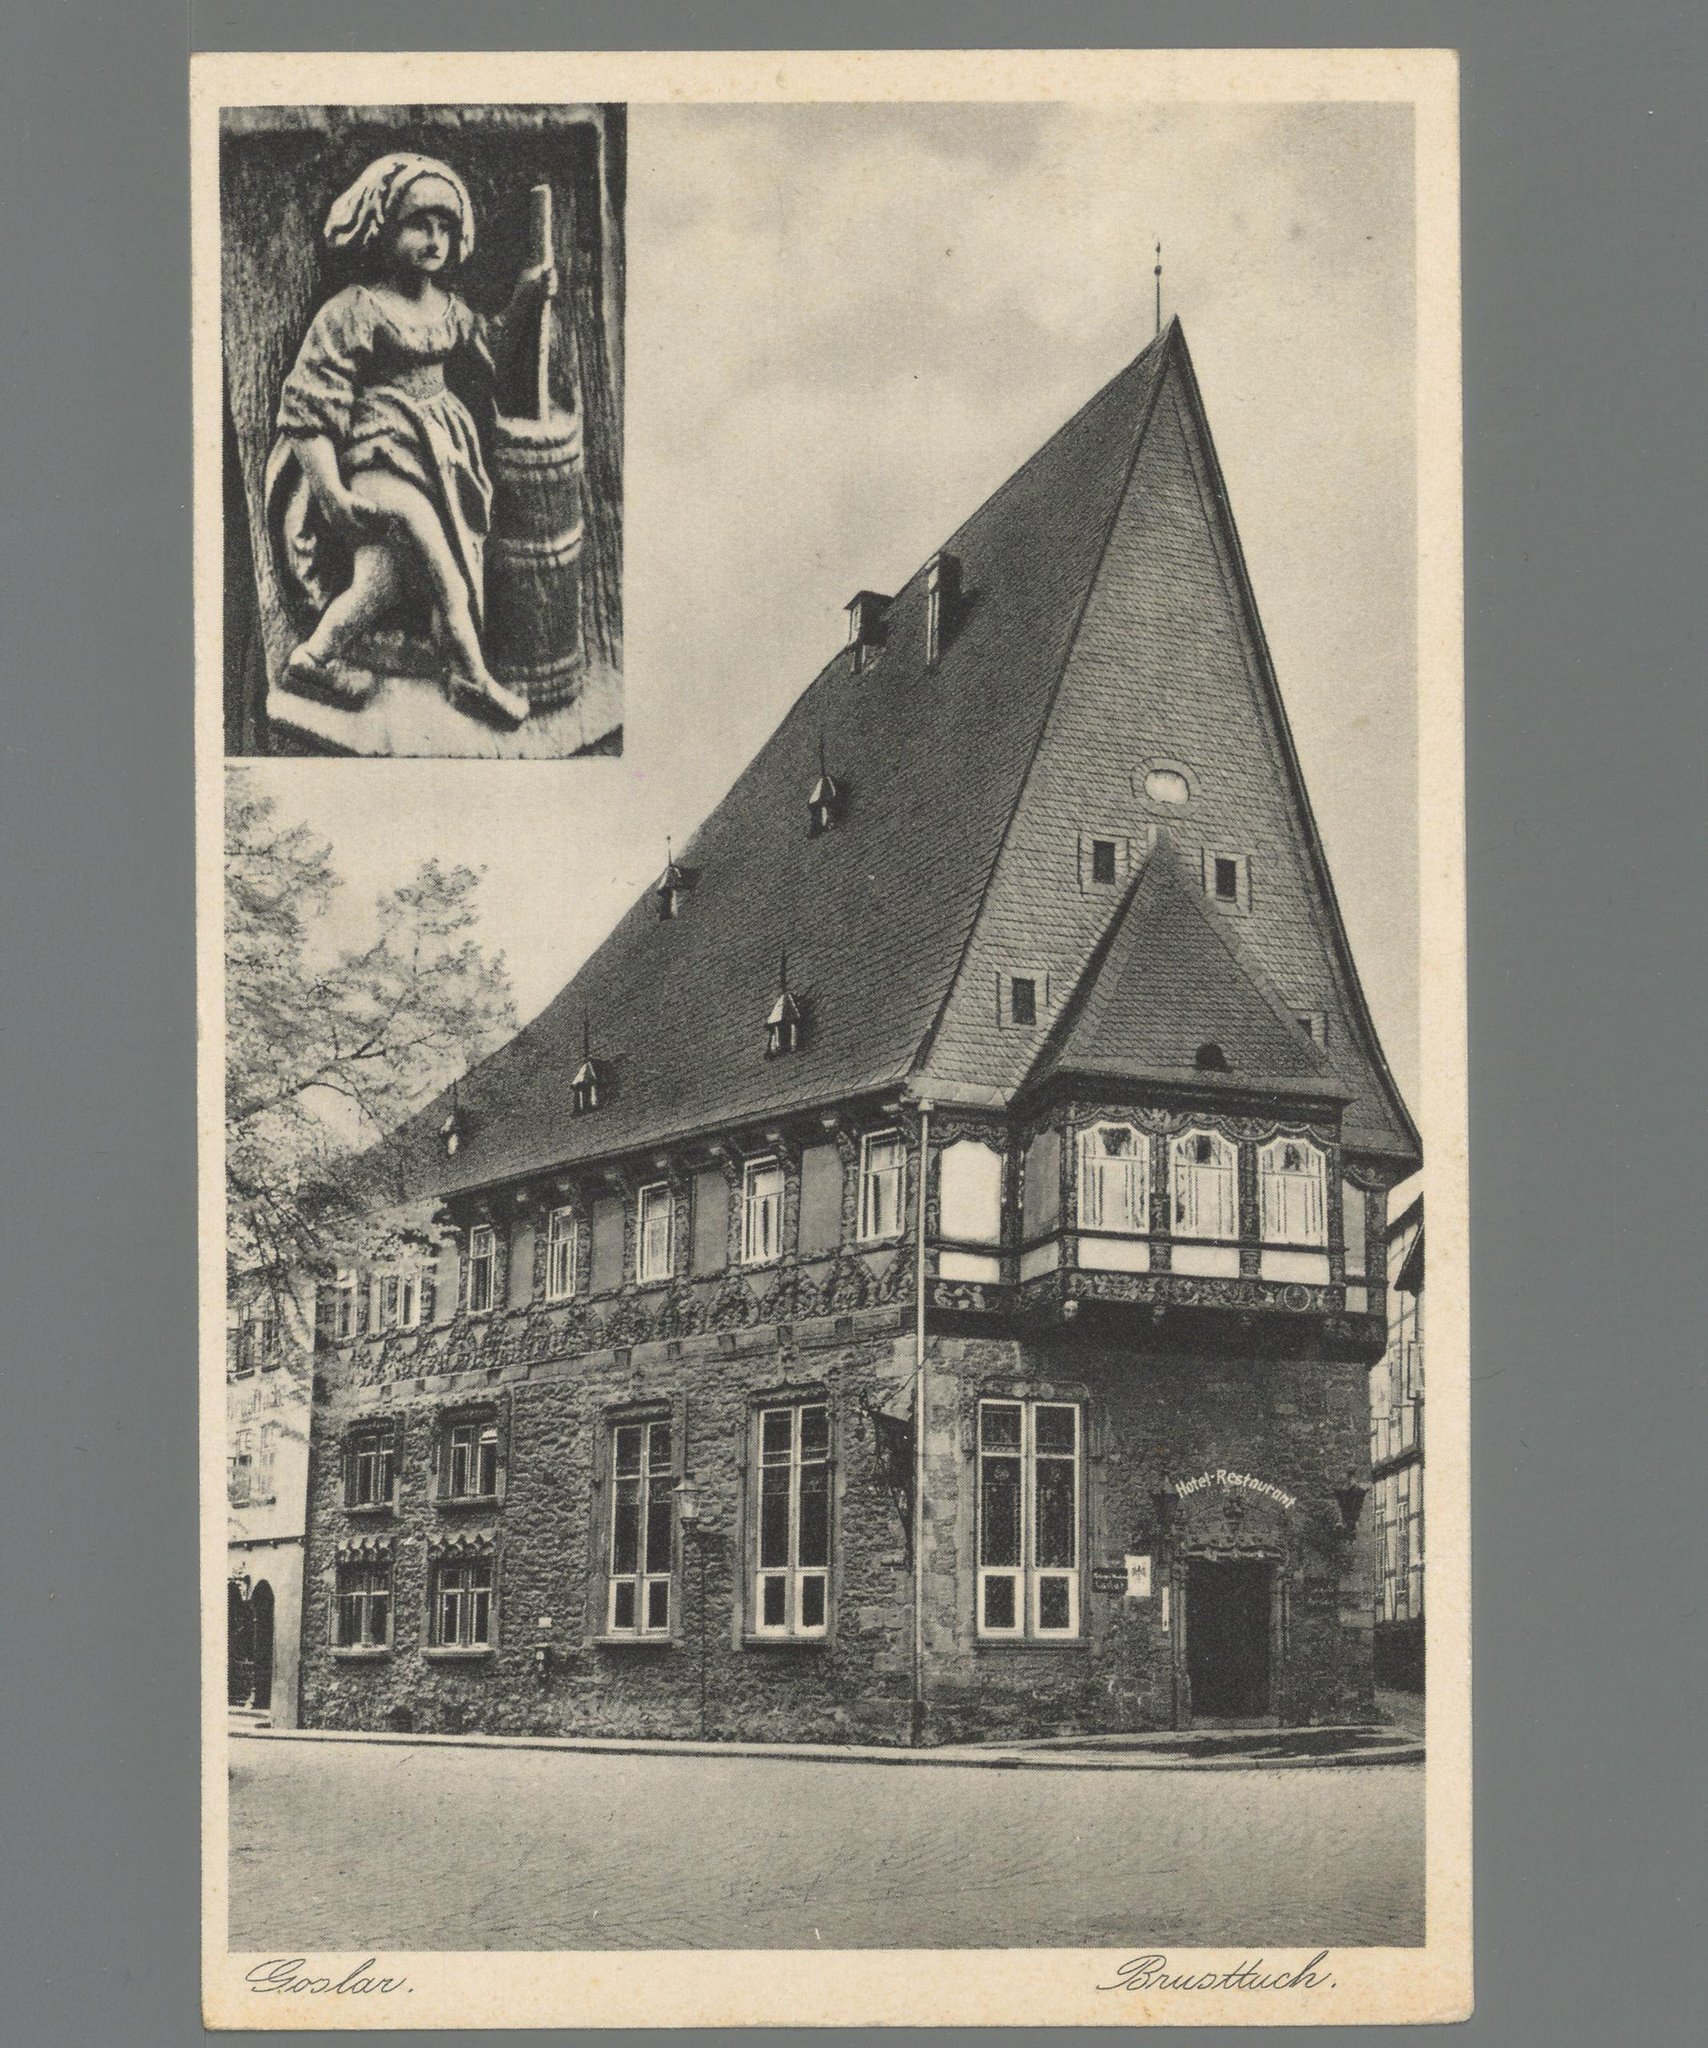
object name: photomechanical print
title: Goslar. Brusttuch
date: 1905-1930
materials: cardboard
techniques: rotogravure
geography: halberstadt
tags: restaurant, hotel, hostelry, inn